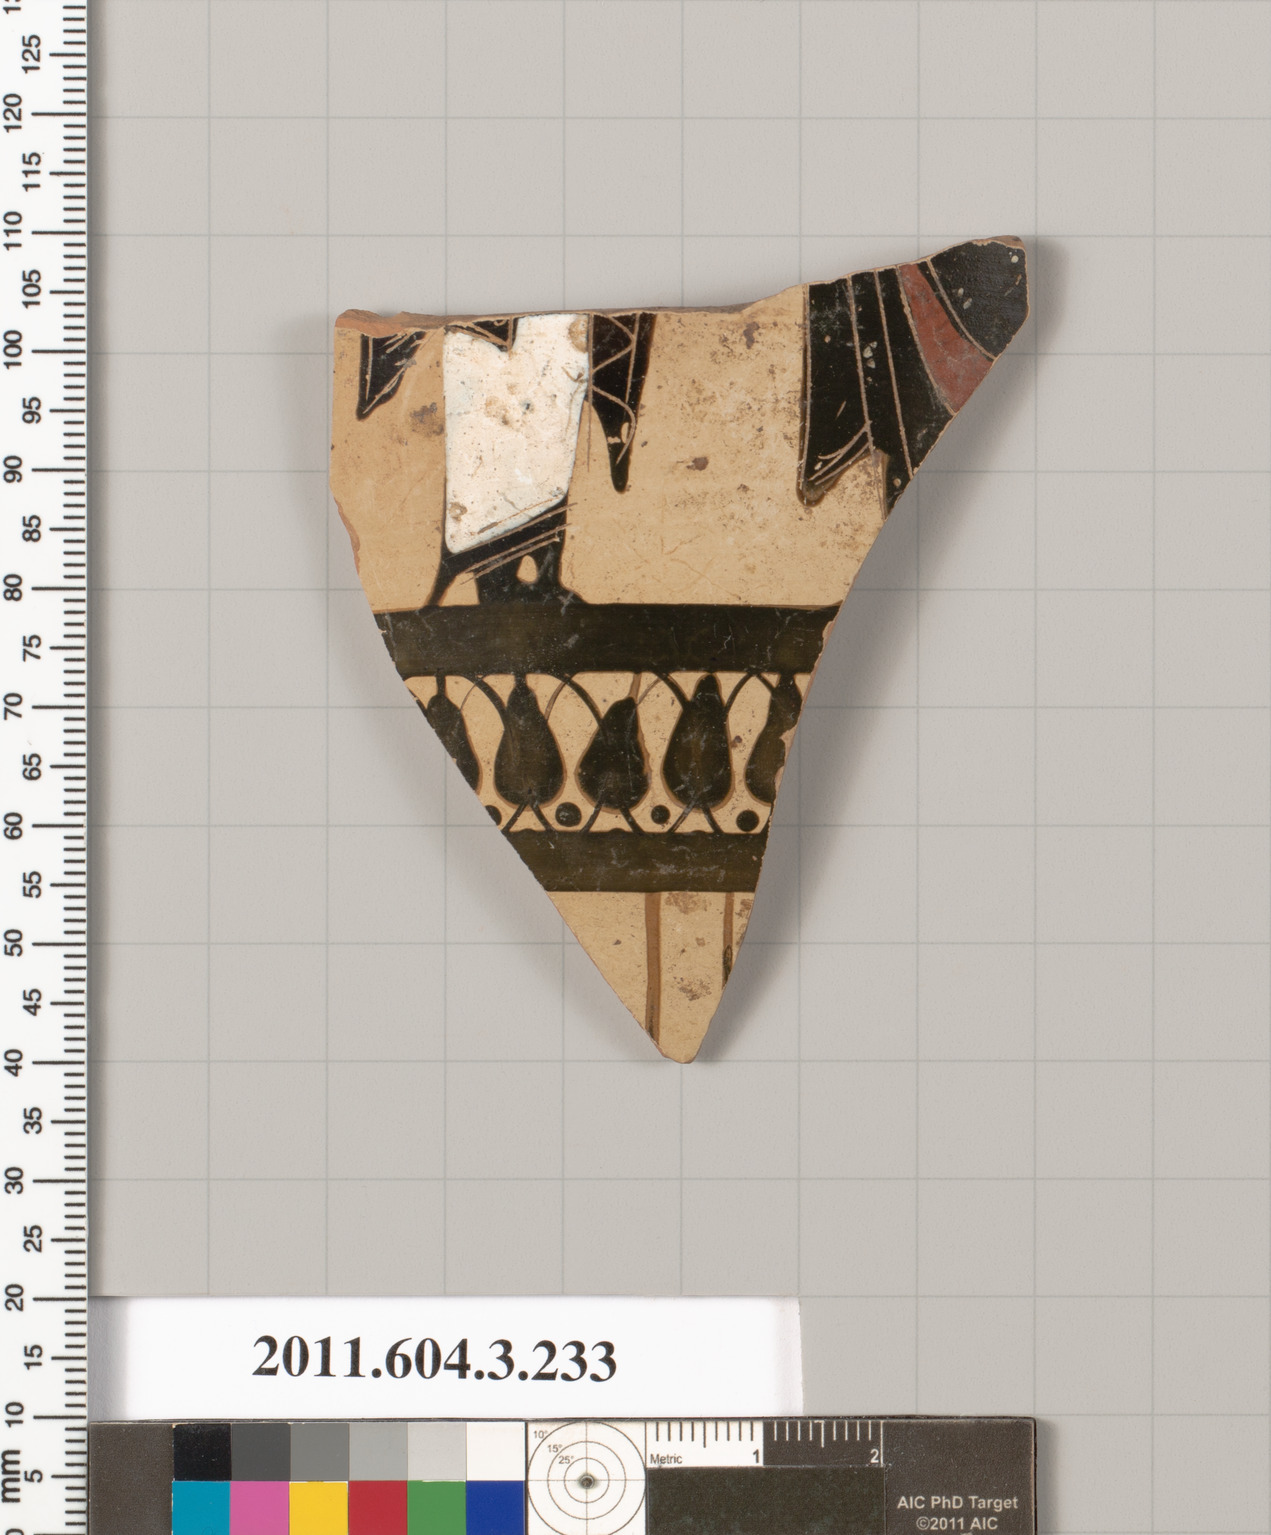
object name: neck amphora fragment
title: Terracotta fragment of a neck-amphora (jar)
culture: greek, attic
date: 534-468 BCE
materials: terracotta